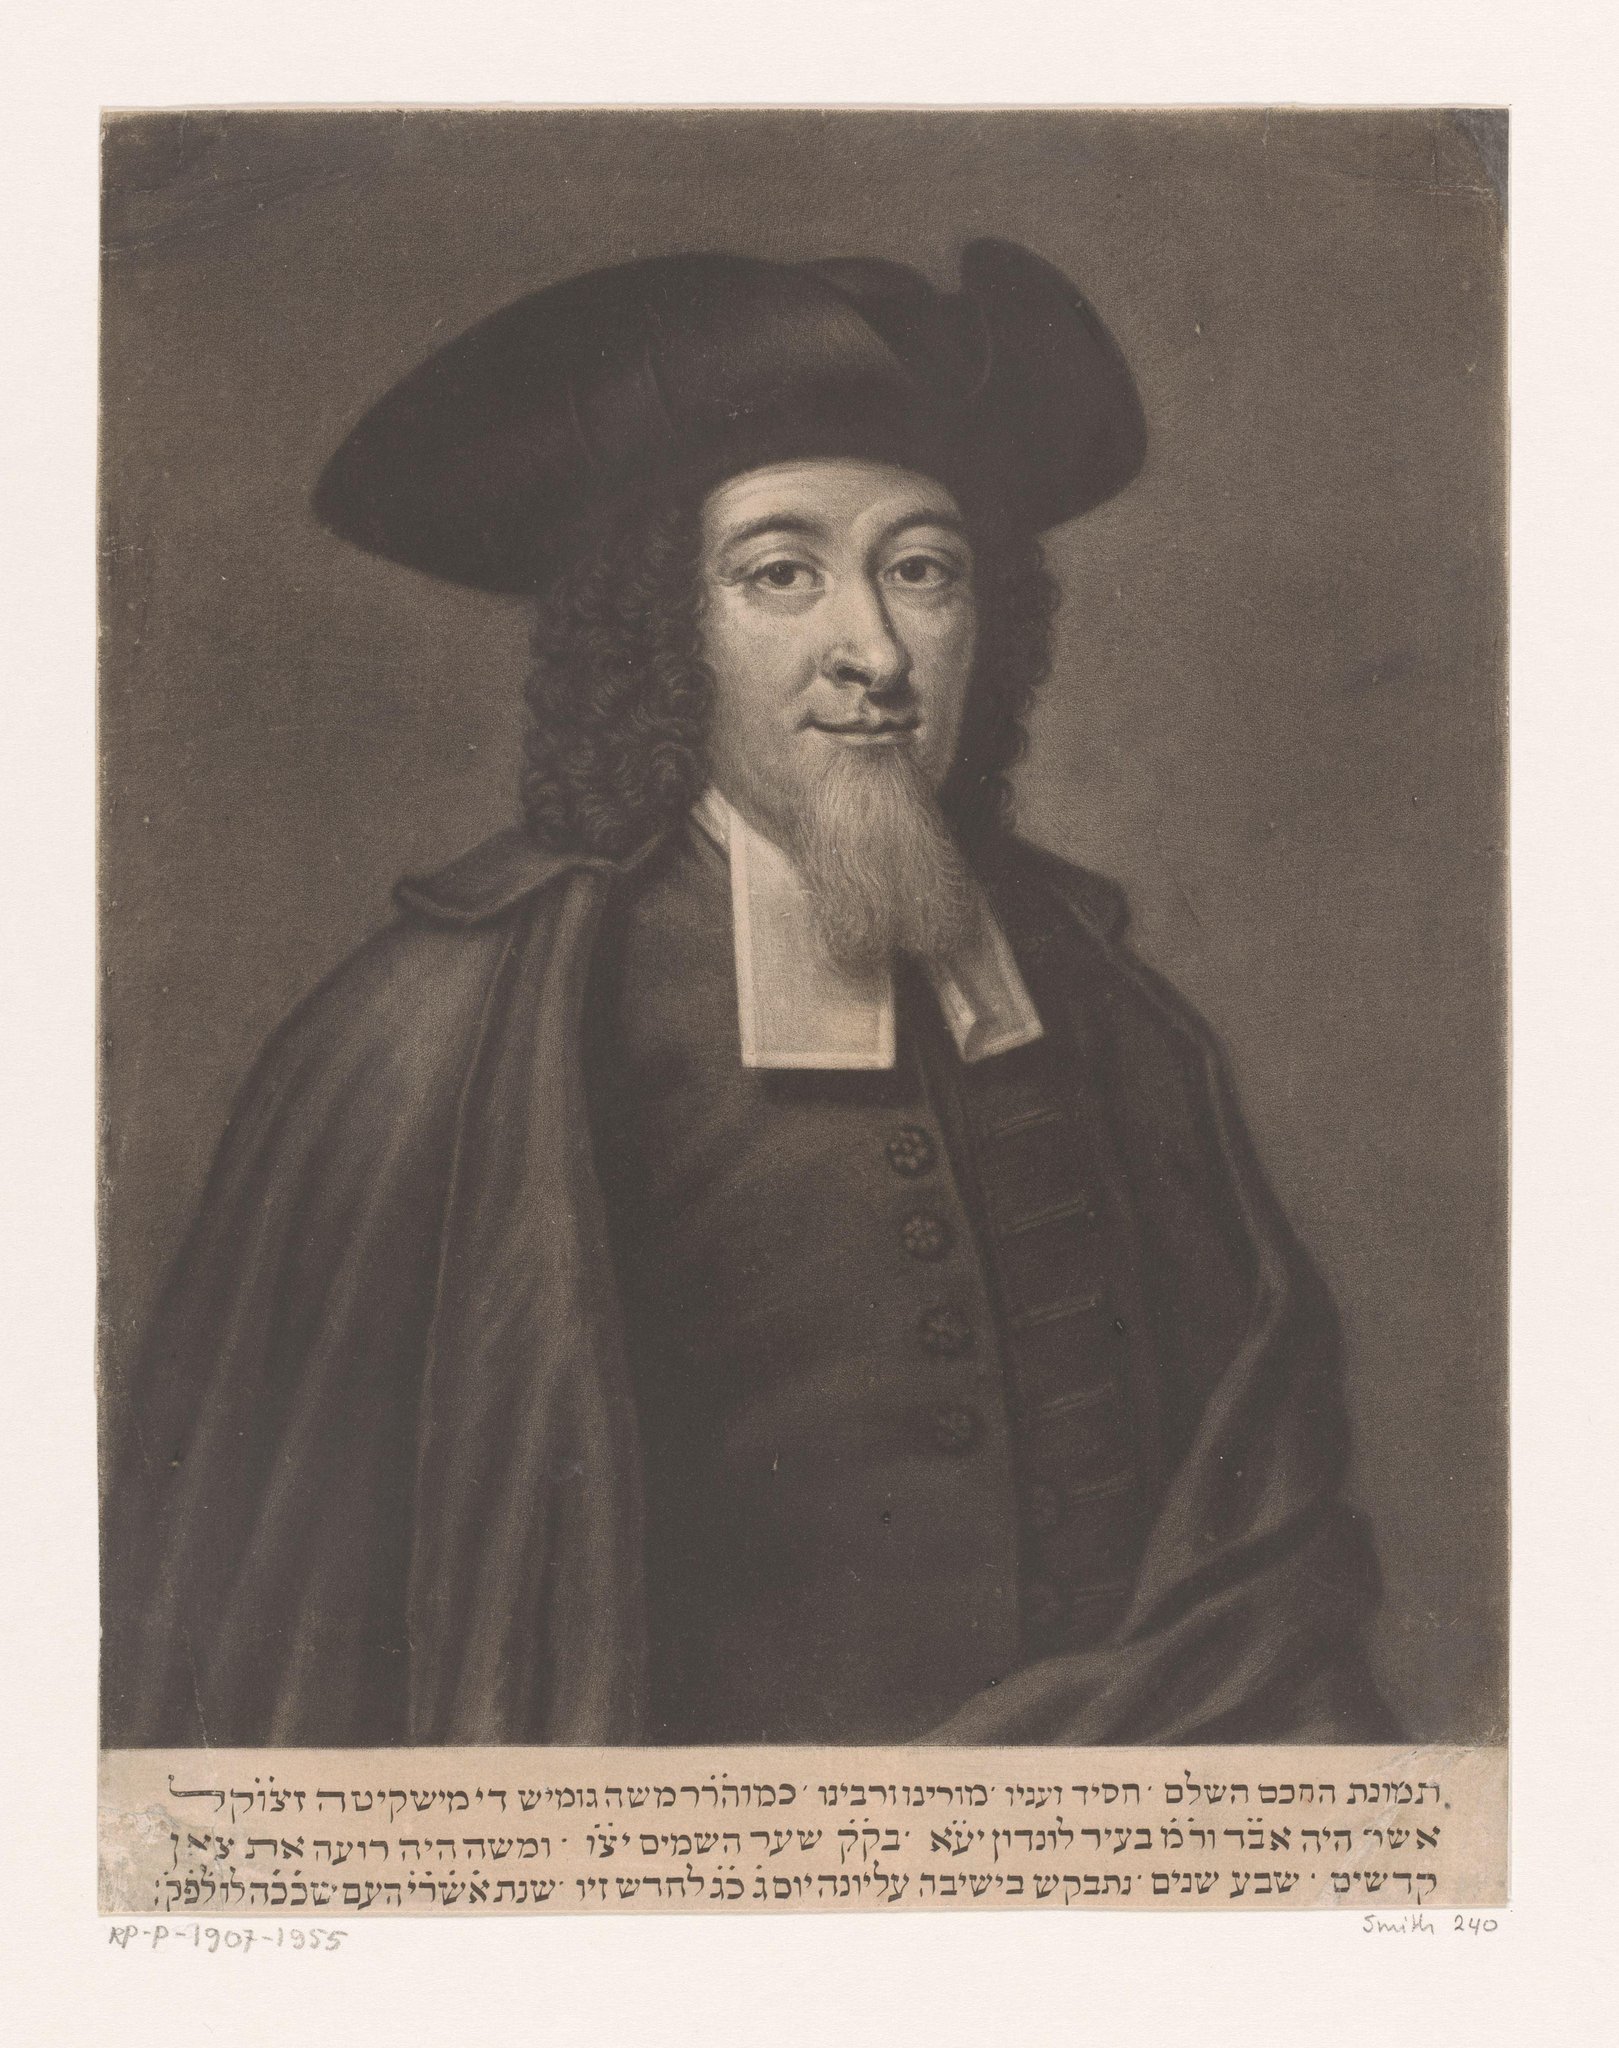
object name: print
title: Portret van Gomez de Mesquita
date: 1752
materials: paper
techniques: mezzotint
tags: historical persons, chief rabbi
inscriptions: collector's mark: Lugt 2228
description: Tekst in het Hebreeuws in de ondermarge.